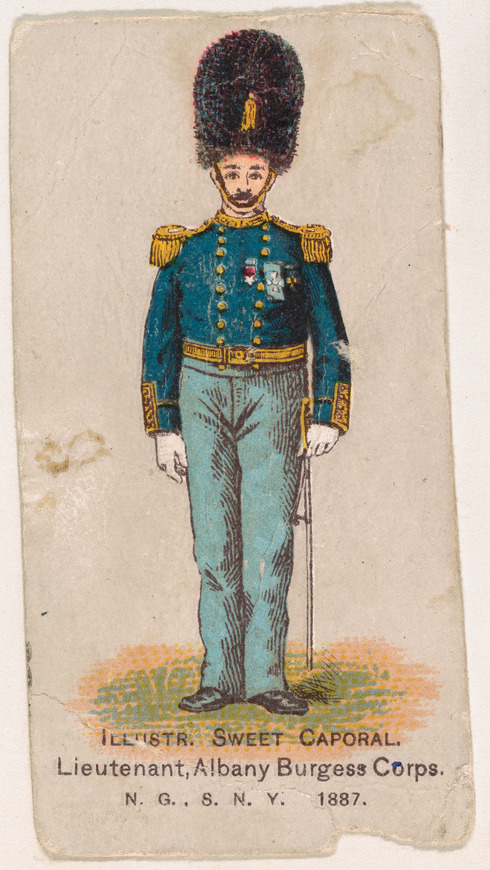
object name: print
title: Lieutenant, Albany Burgess Corps., National Guard of the State of New York, 1887, from the Military Series (N224) issued by Kinney Tobacco Company to promote Sweet Caporal Cigarettes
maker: kinney brothers tobacco company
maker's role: publisher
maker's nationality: american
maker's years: 1869-2011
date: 1888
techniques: color lithograph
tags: soldiers,swords,men